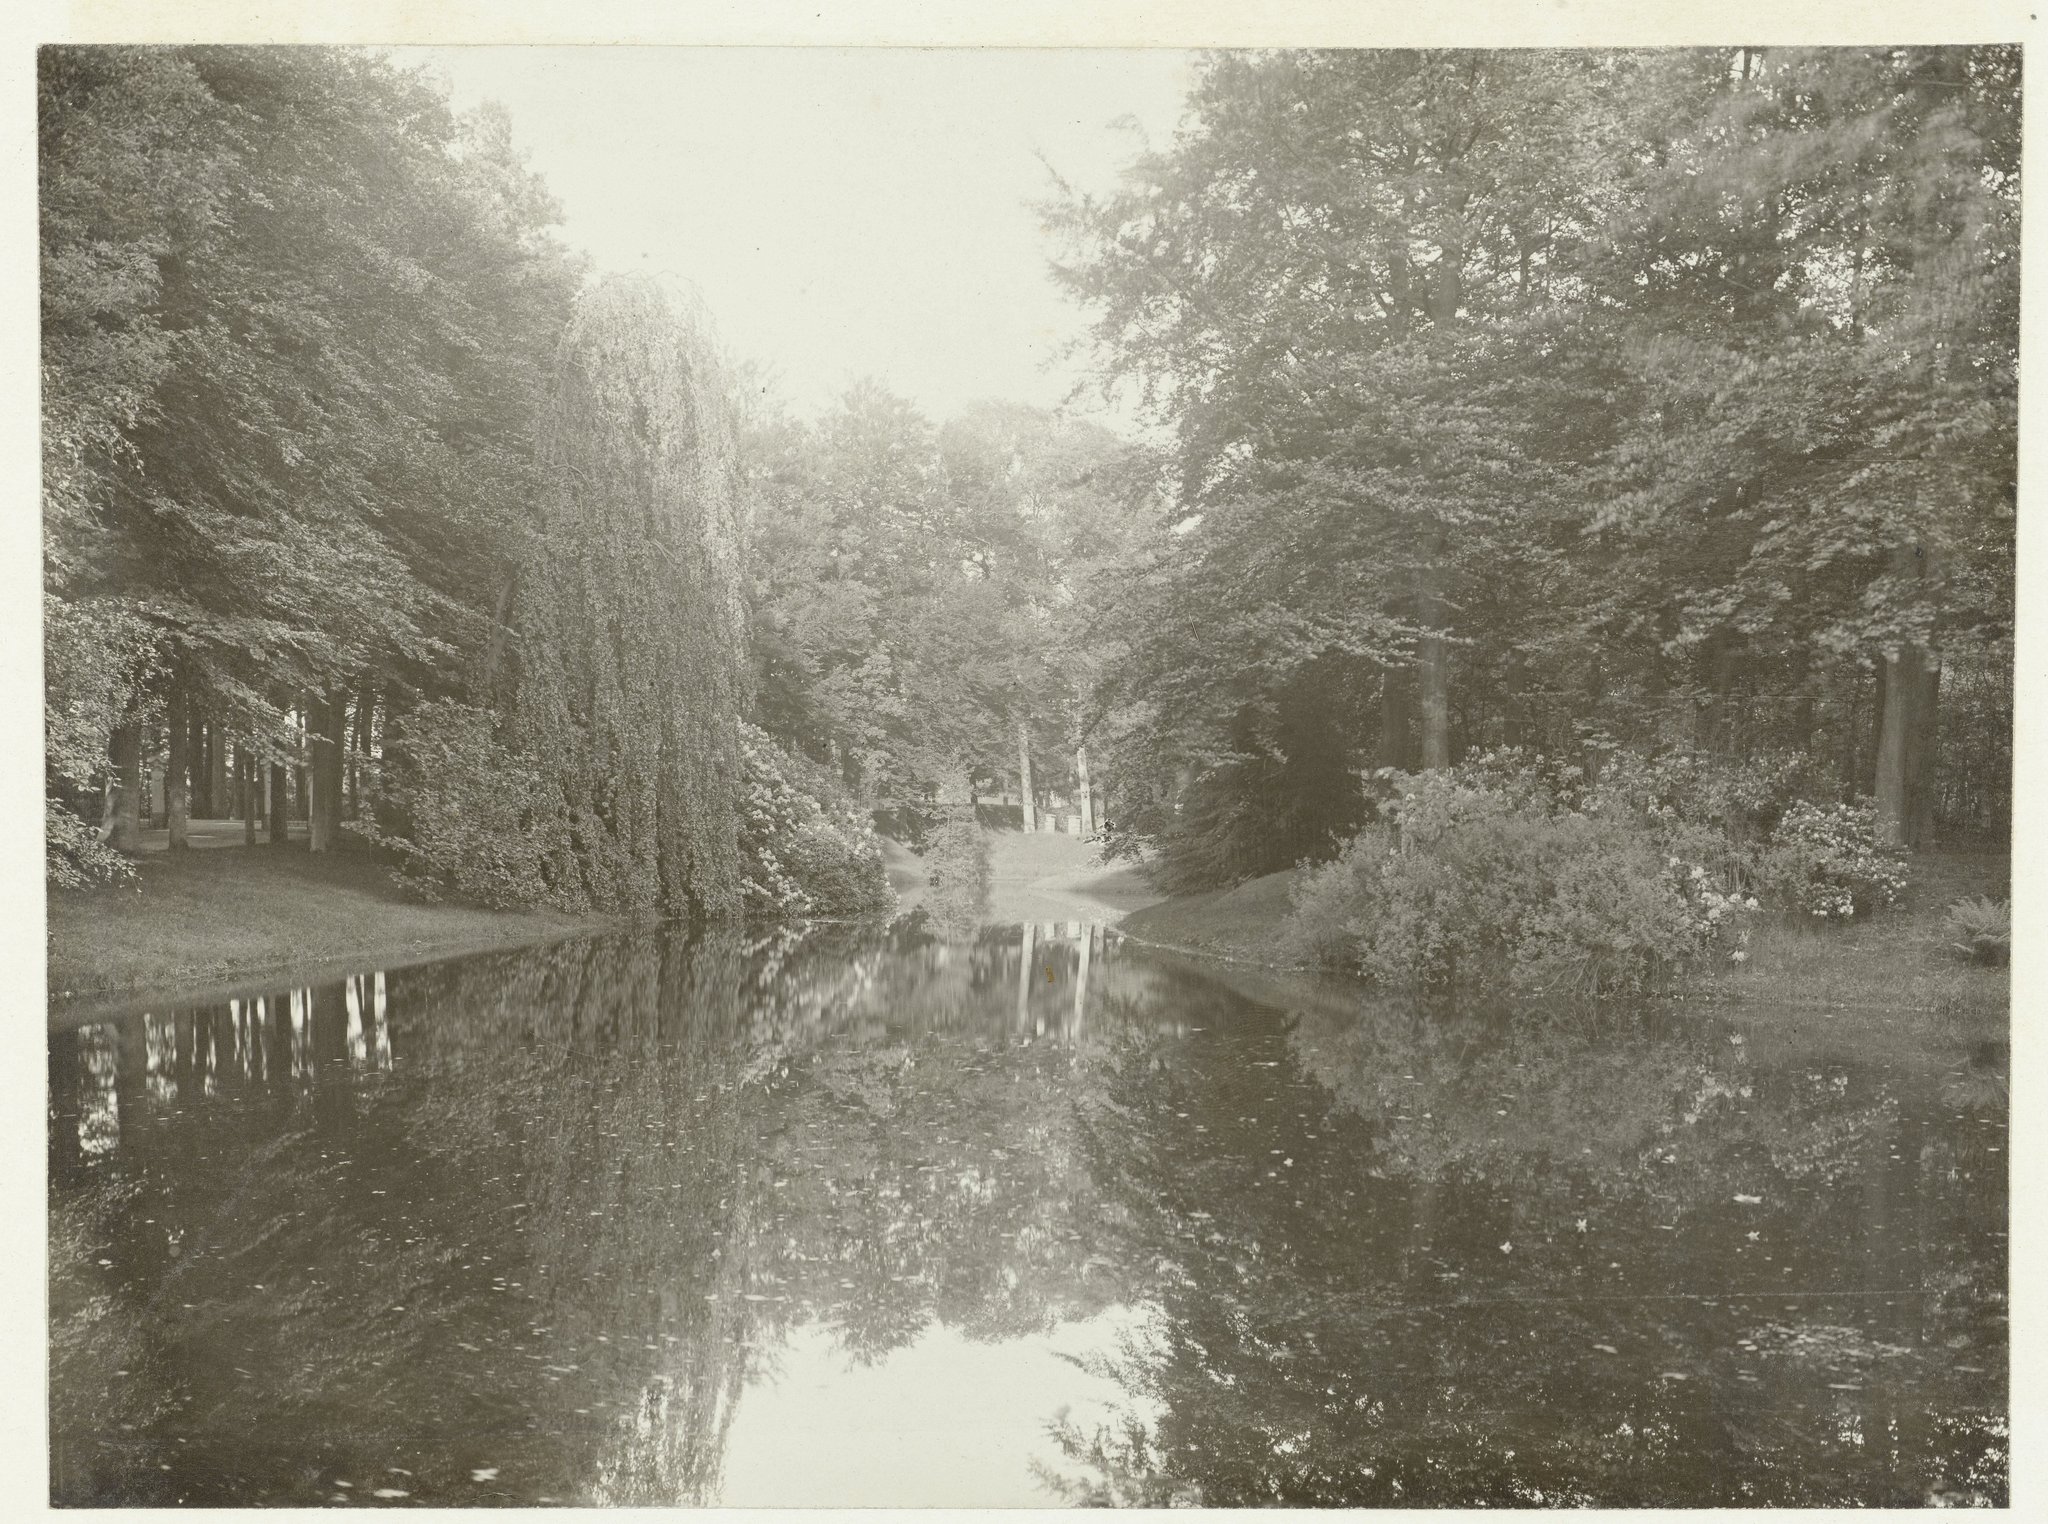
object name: photograph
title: Gezicht op landhuis De Wildbaan, Driebergen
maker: henry pauw van wieldrecht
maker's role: fotograaf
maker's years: 1863-1912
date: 1903-1907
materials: paper, photographic support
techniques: gelatin silver print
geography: netherlands